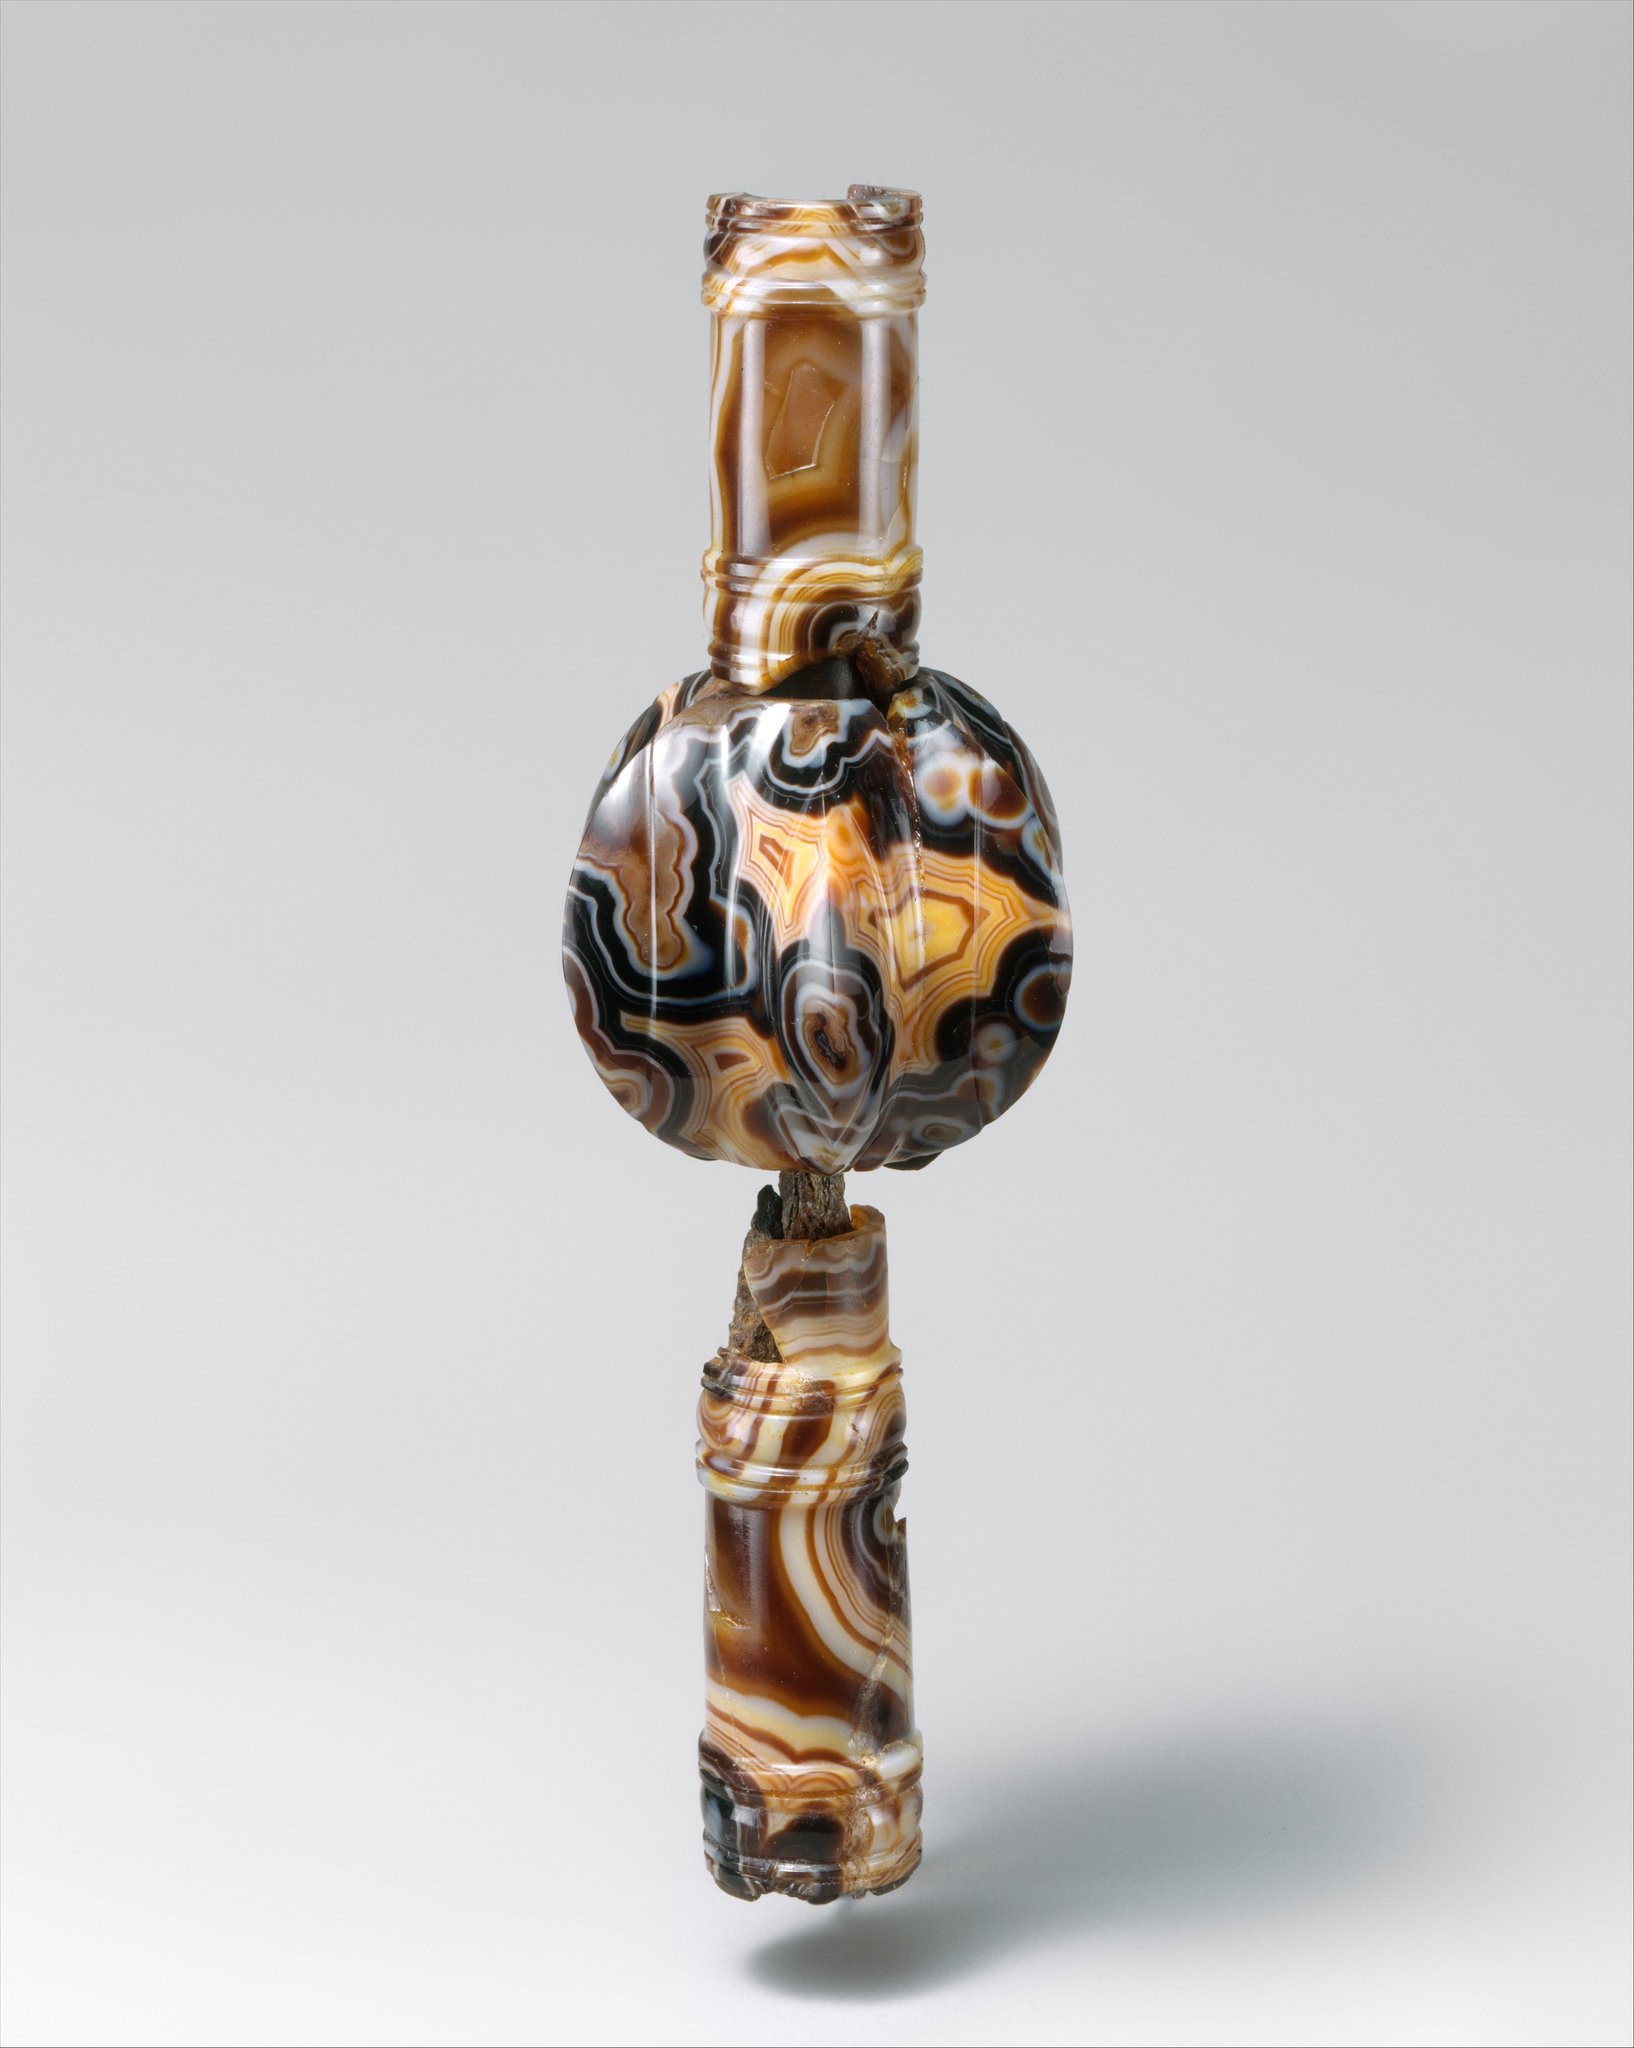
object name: scepter head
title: Agate scepter head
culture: cypriot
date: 950 BCE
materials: stone